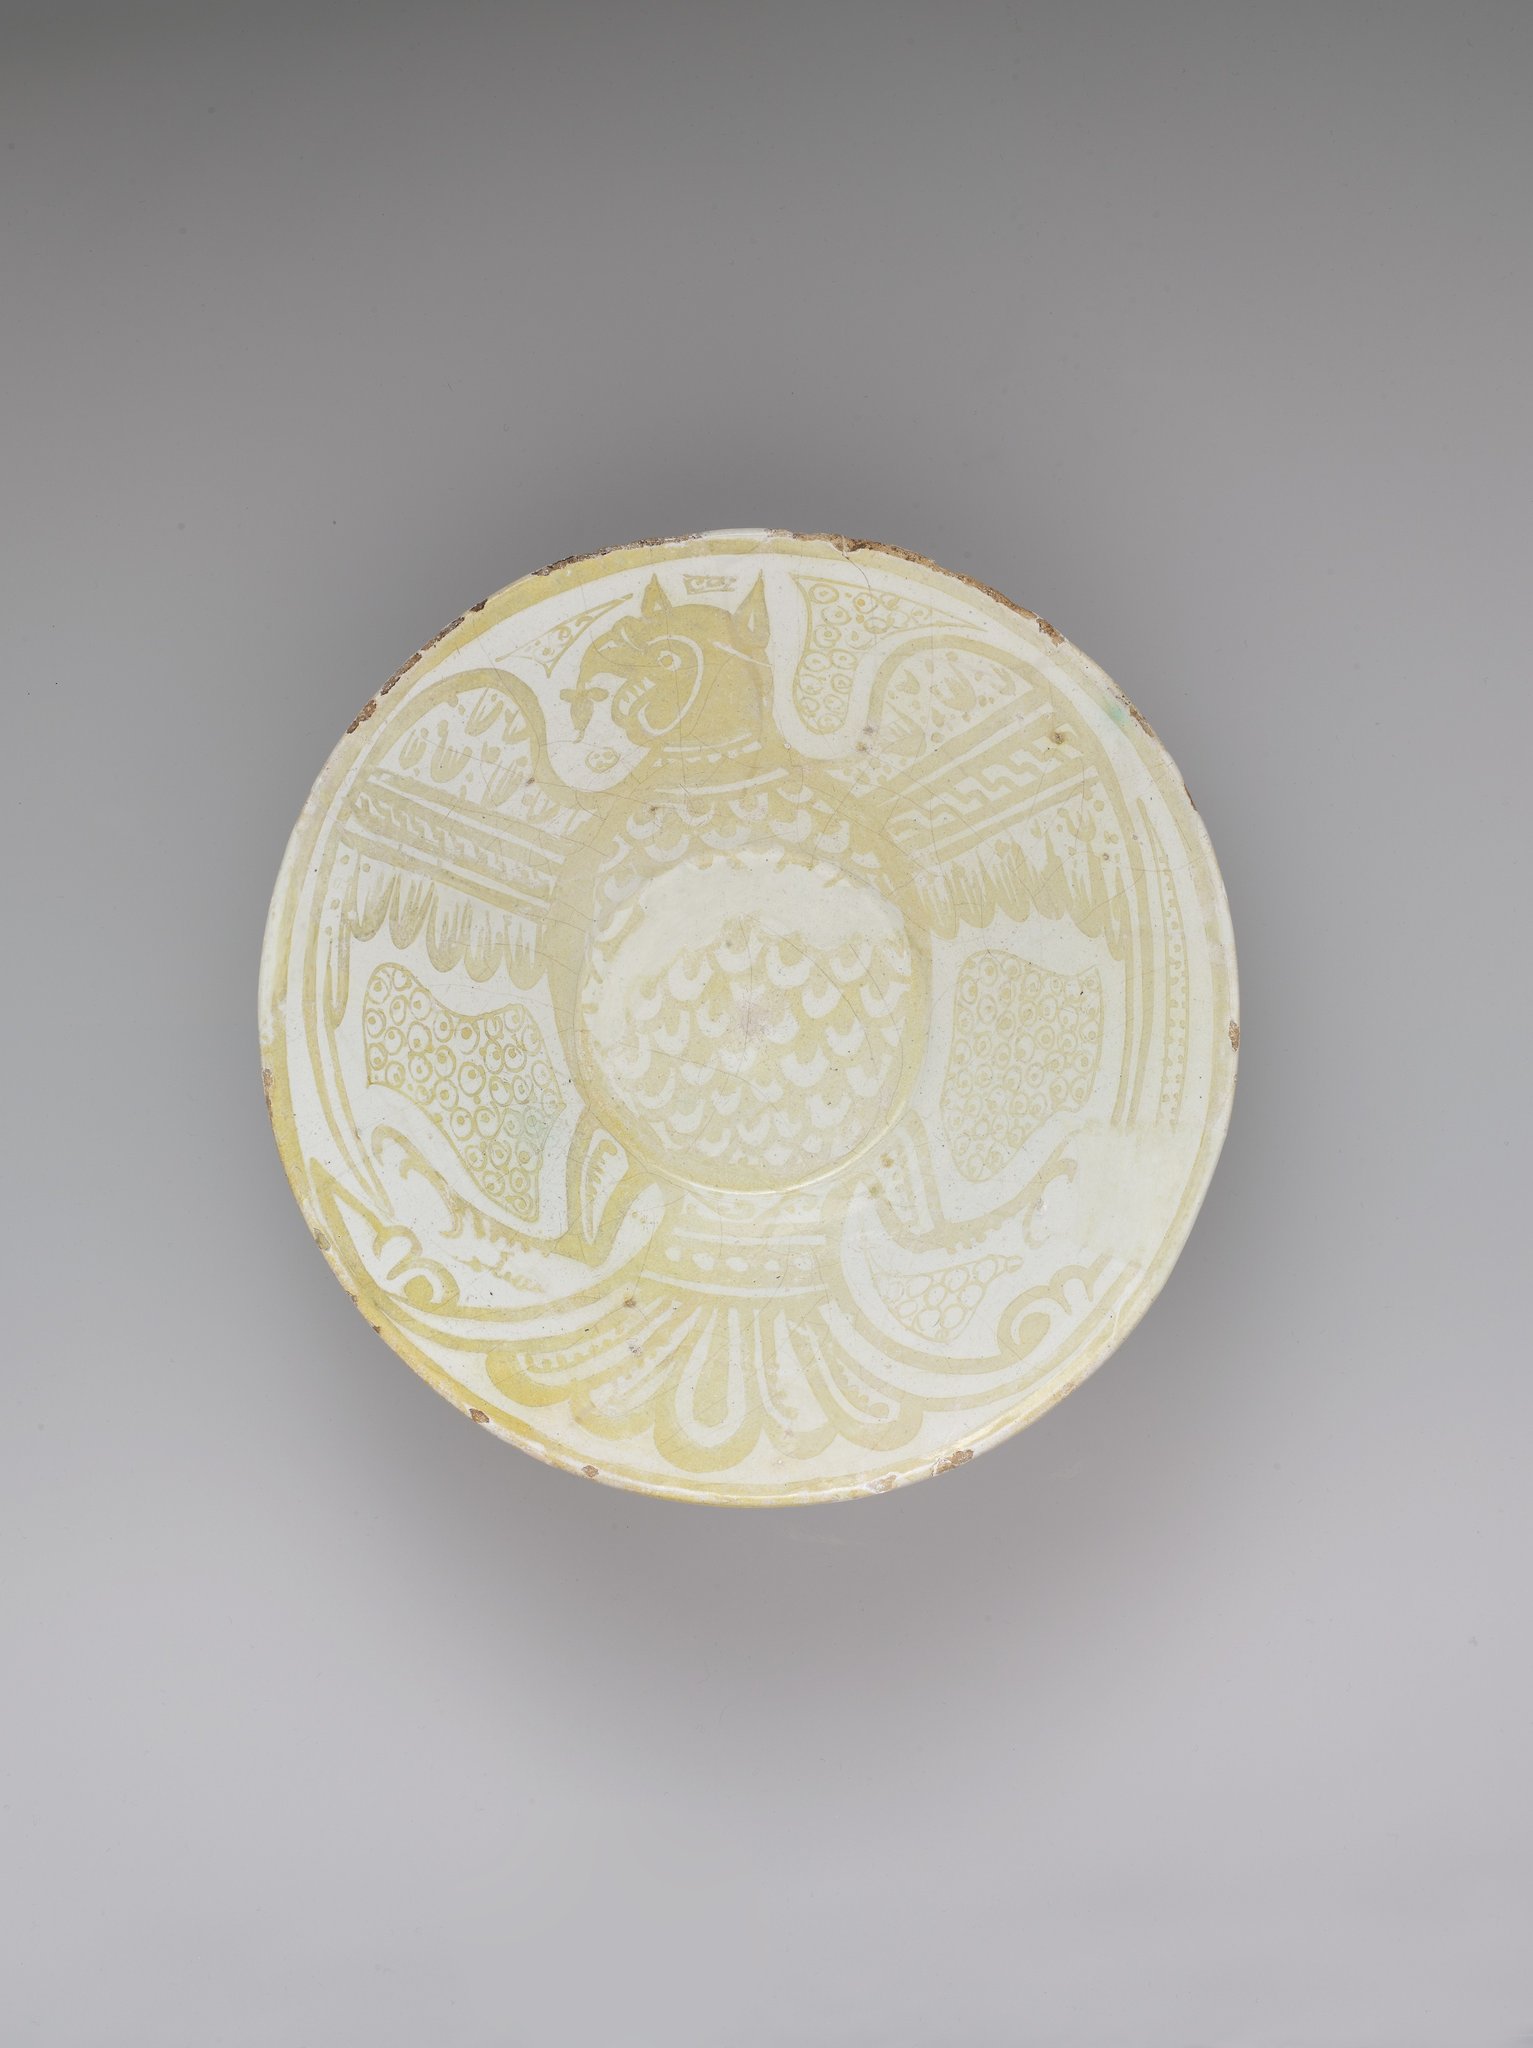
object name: bowl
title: Bowl with Eagle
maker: muslim ibn al-dahhan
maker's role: maker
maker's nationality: egyptian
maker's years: 975-1025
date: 1000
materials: earthenware, glaze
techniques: luster painting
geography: egypt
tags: eagles